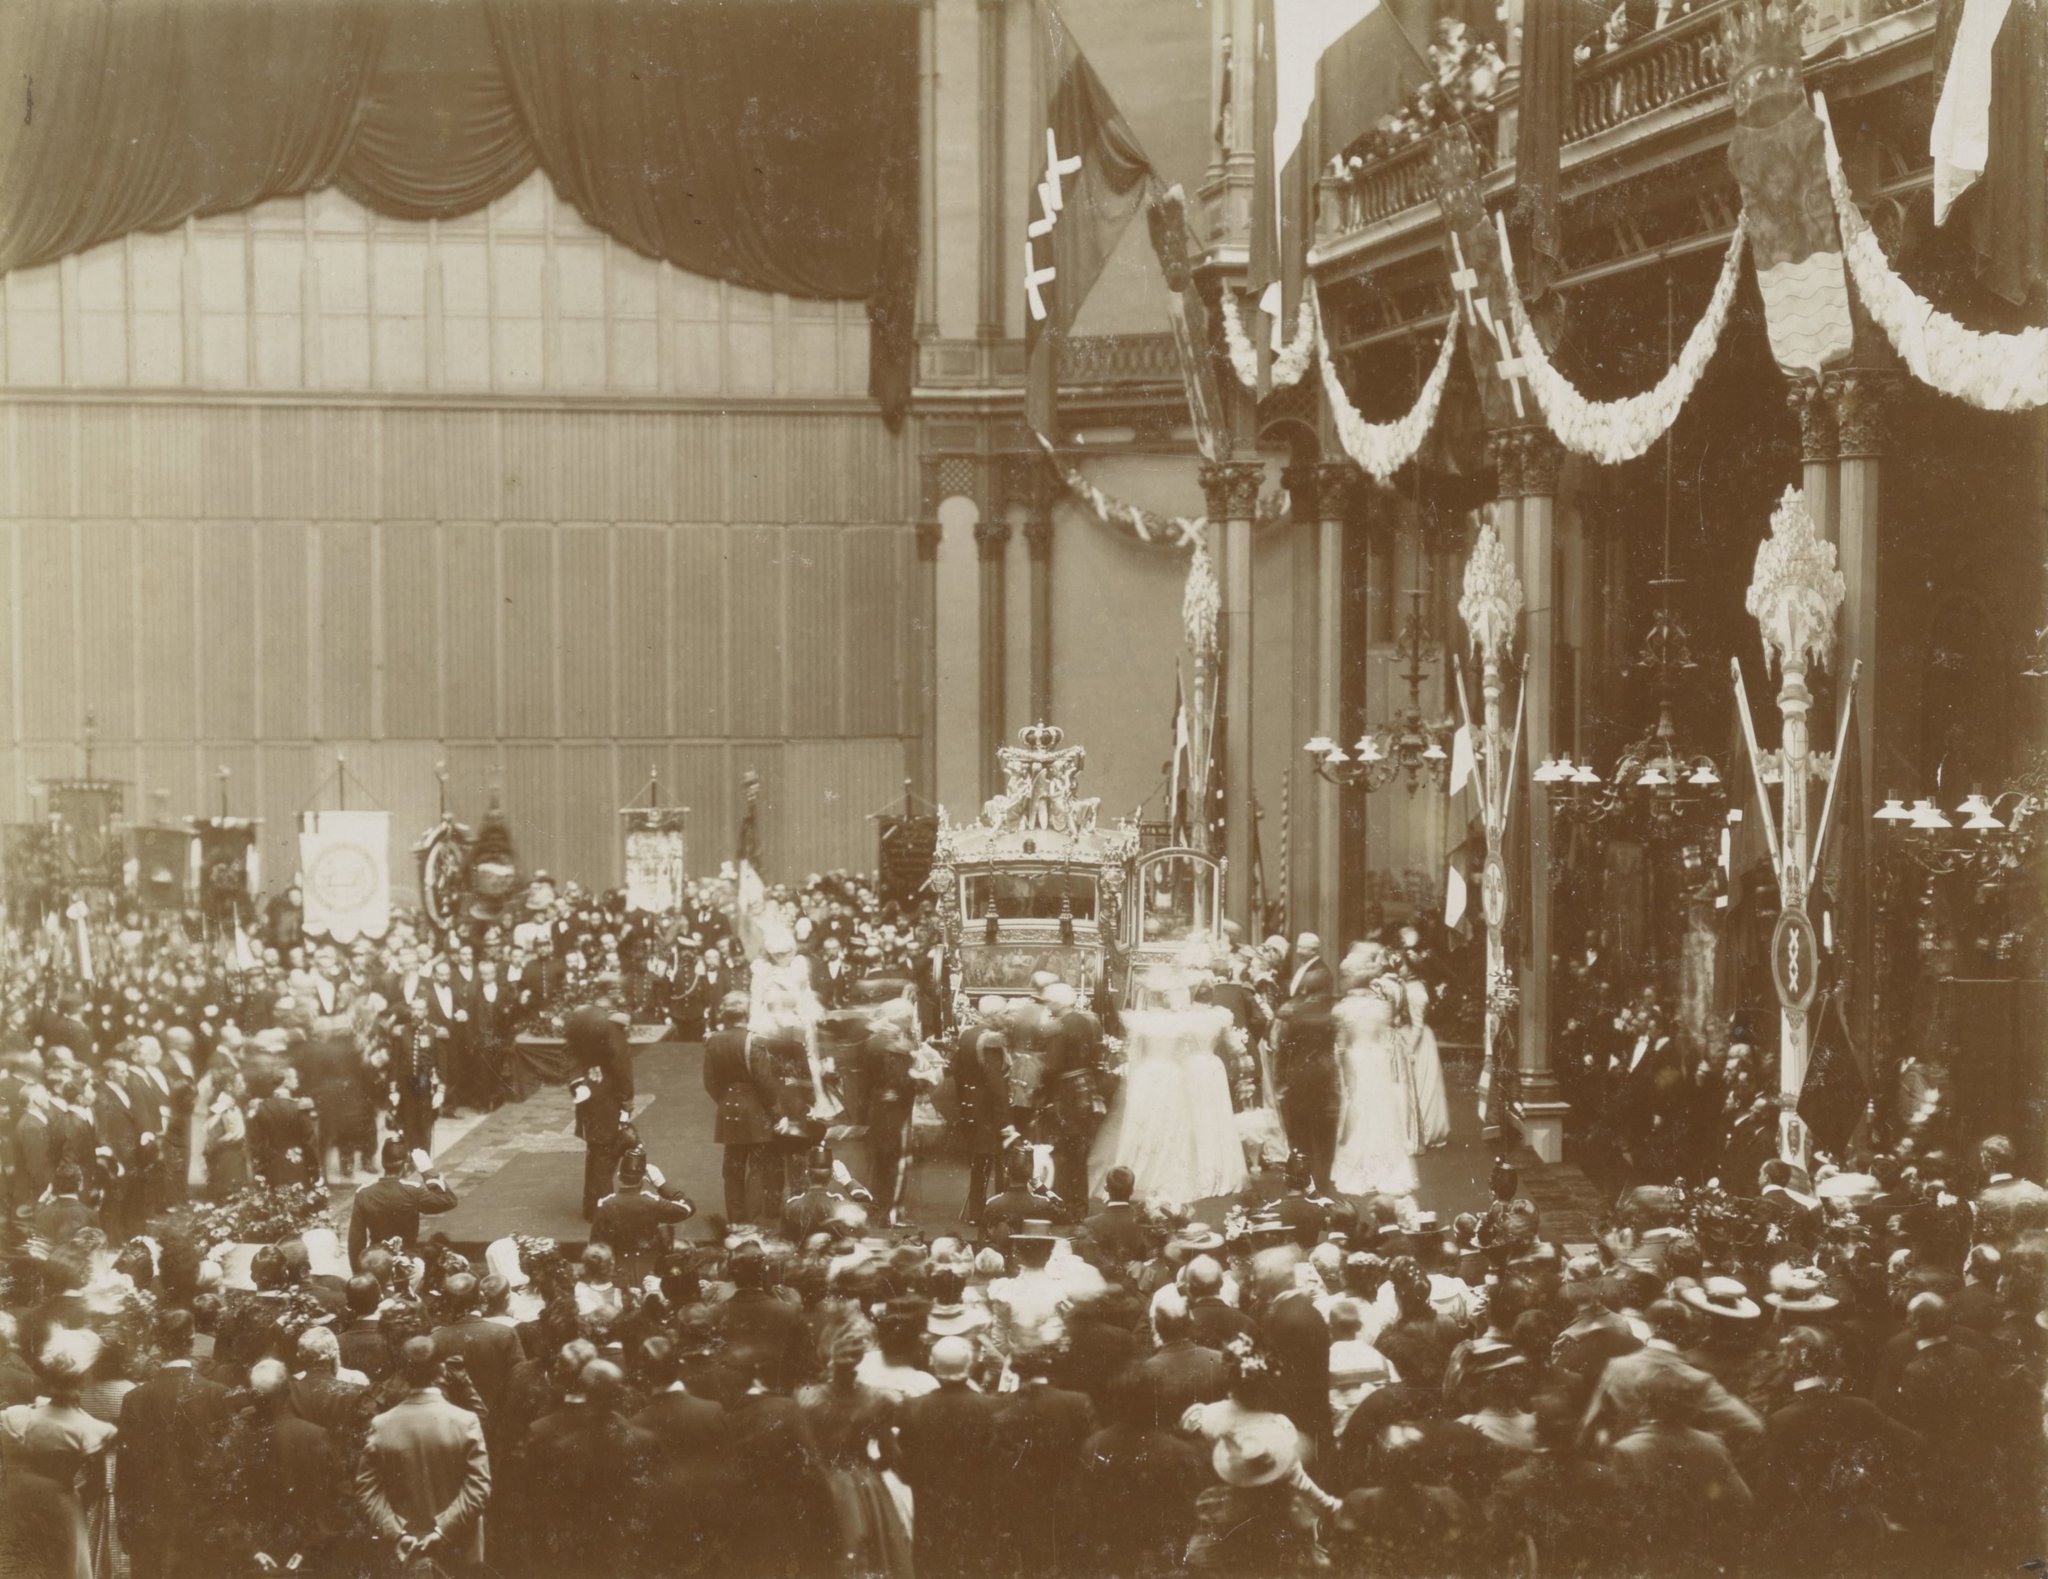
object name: photograph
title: Ingebruikneming van de Gouden Koets[onz]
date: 1898-1910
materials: cardboard, photographic support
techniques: albumen print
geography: amsterdam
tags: amsterdam